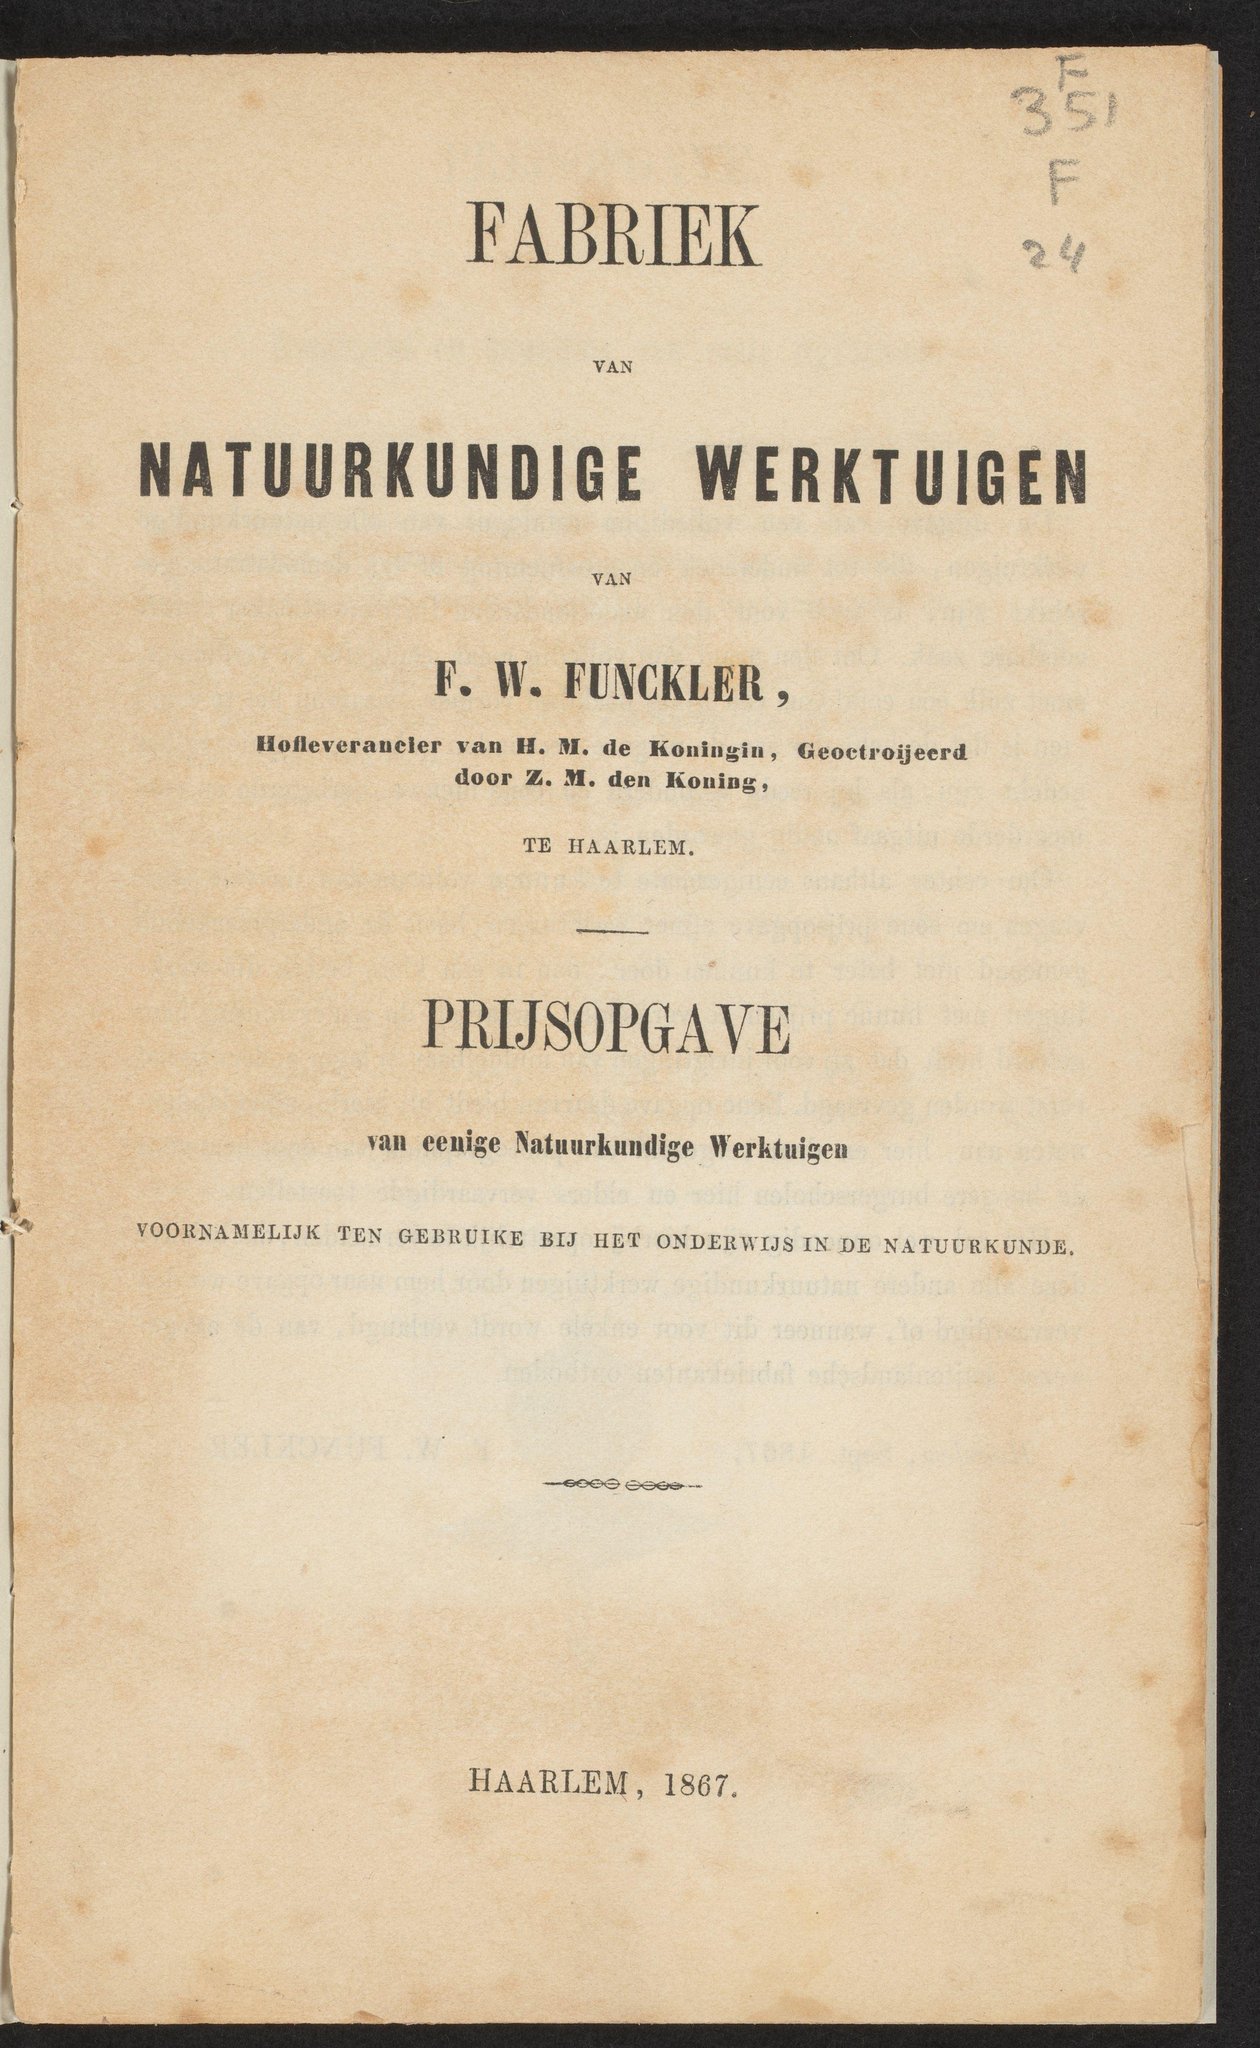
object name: photograph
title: Natuurkundige instrumenten van F.W. Funckler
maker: fredrich wilhelm funckler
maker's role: instrument maker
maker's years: 1836-1886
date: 1857-1867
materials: photographic support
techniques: albumen print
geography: netherlands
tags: physics and mechanics